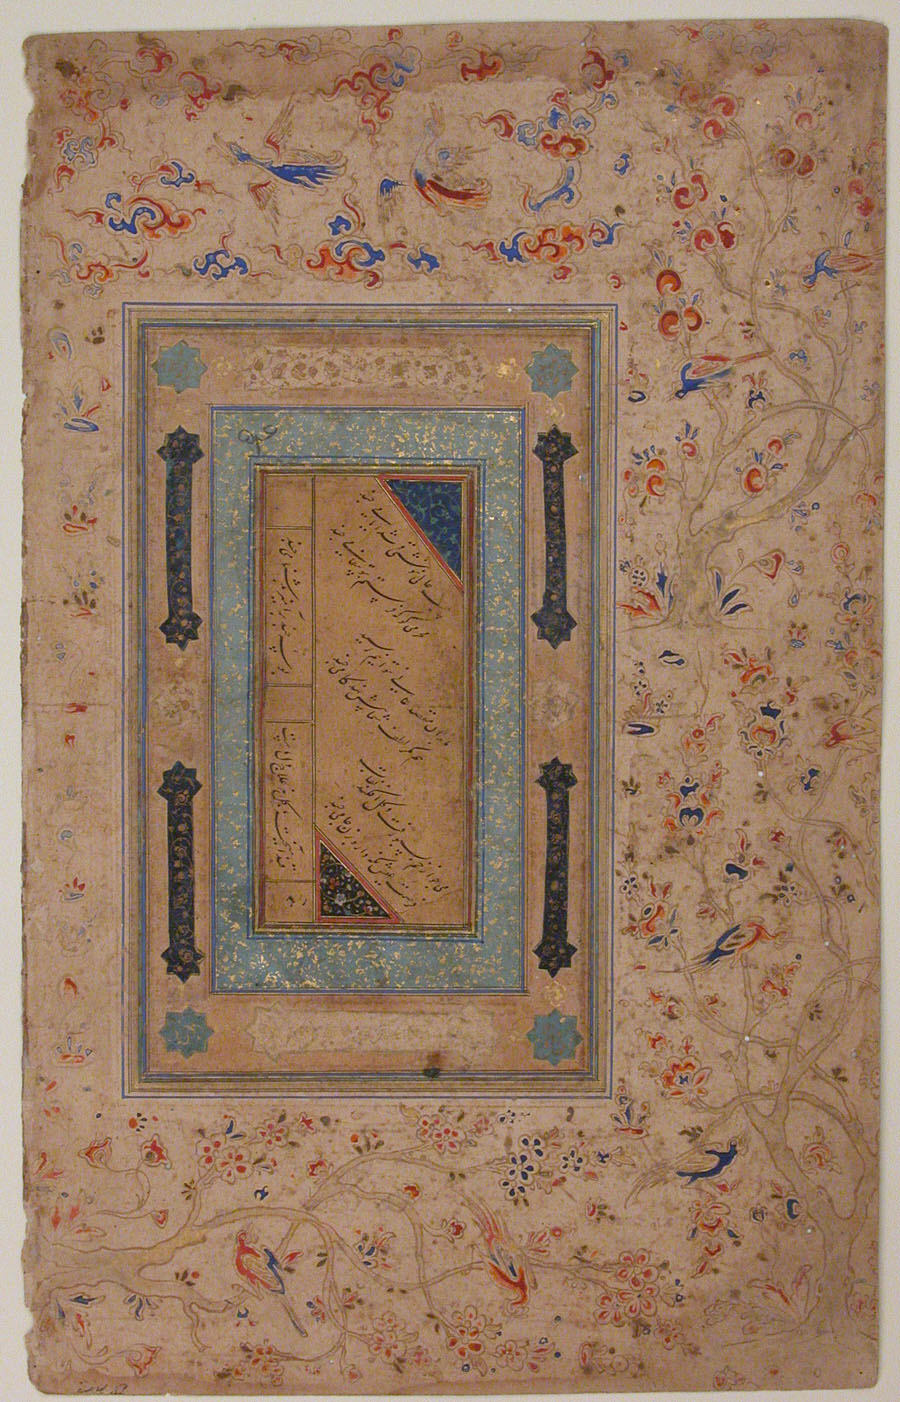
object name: non illustrated single work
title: Page of Calligraphy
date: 1601-1700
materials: gold, ink, paper, watercolor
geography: india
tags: calligraphy